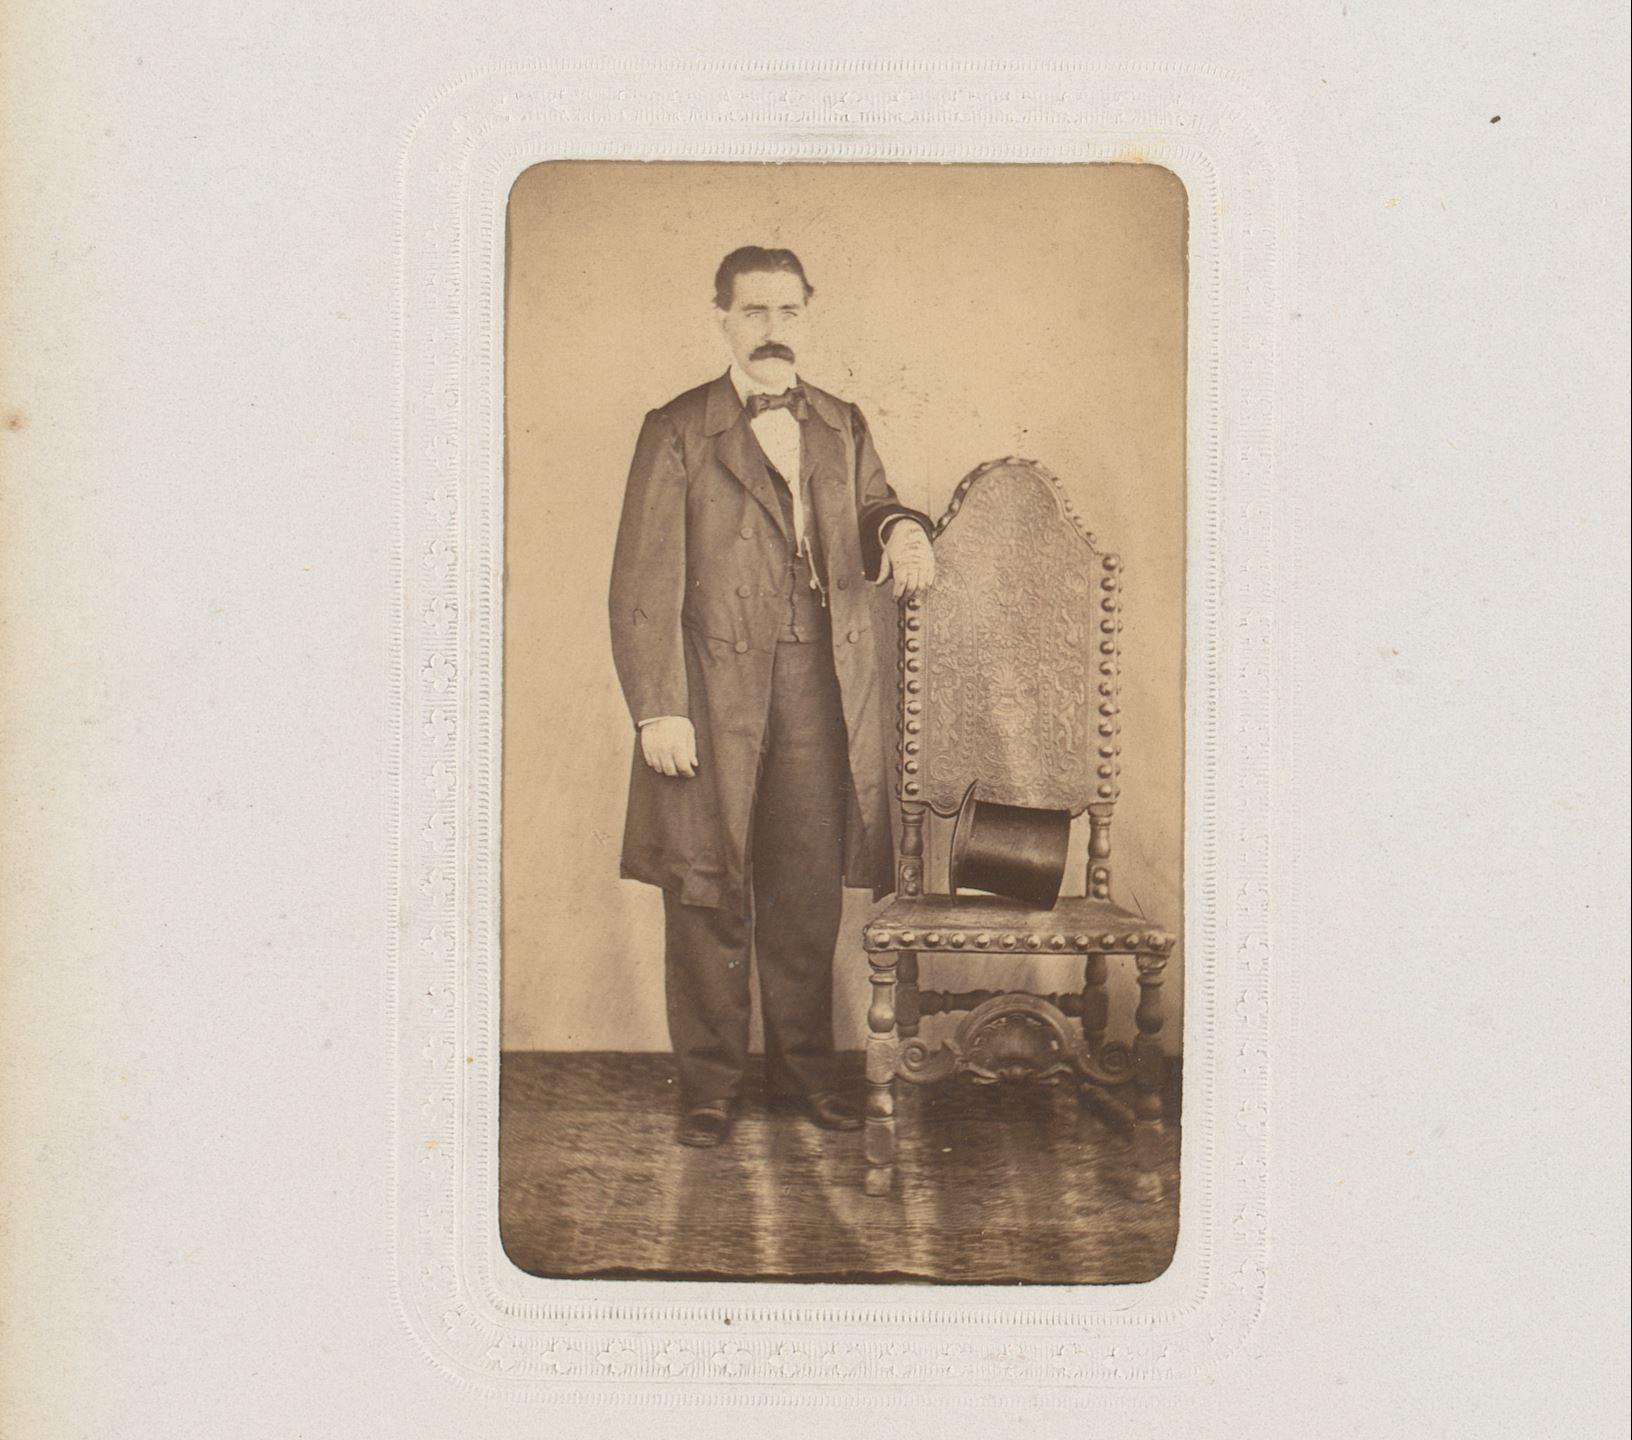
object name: photograph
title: Portret van een man, staand bij een stoel met hoge hoed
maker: Anonymous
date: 1860-1890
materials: cardboard, photographic support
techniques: albumen print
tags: standing figure, historical persons, head-gear: top hat